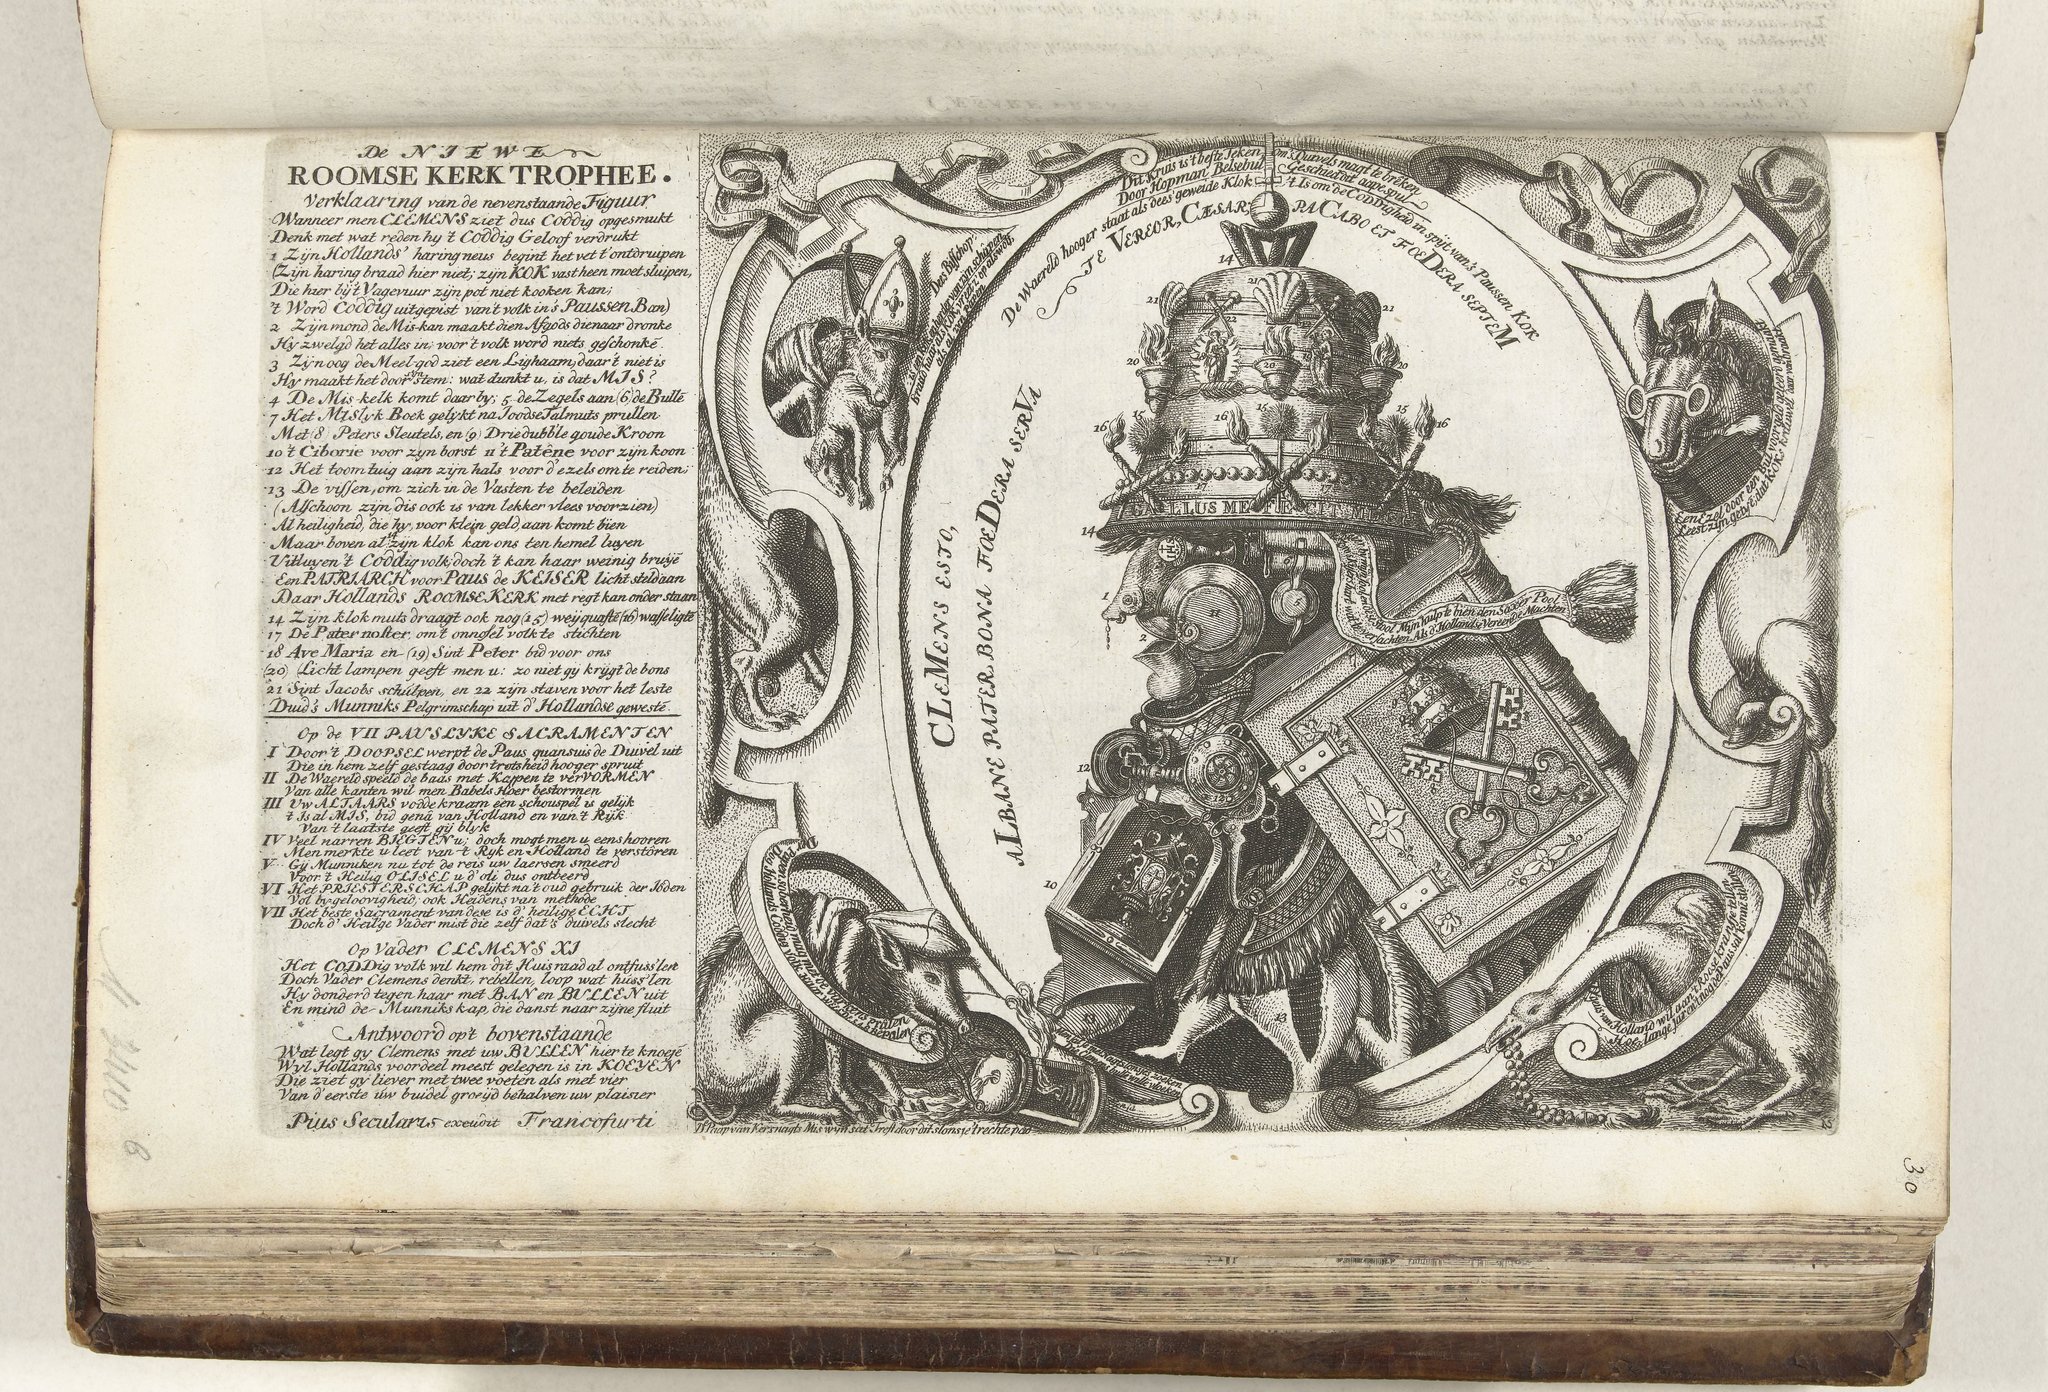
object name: cartoon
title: Spotprent op paus Clemens XI, 1705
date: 1706-1707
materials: paper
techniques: etching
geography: amsterdam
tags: rome, clergyman, clemens xi, utrecht, reformation (roman catholic church vs. protestantism), pope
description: Grotesk portret van paus Clemens XI, 1705. Hoofd van de paus op de manier van Arcimboldo opgebouwd uit allerlei objecten die gerelateerd zijn aan de katholieke kerk. Blad nr. 2 in de serie van 13 bladen met spotprenten op de jezuïeten getiteld Roma Pertubata, 1707. Onderdeel van het prentwerk uitgegeven onder de verzameltitel 't Lust-Hof van Momus met de gebundelde series van spotprenten tijdens de jaren 1701-1713 van de Spaanse Successieoorlog.